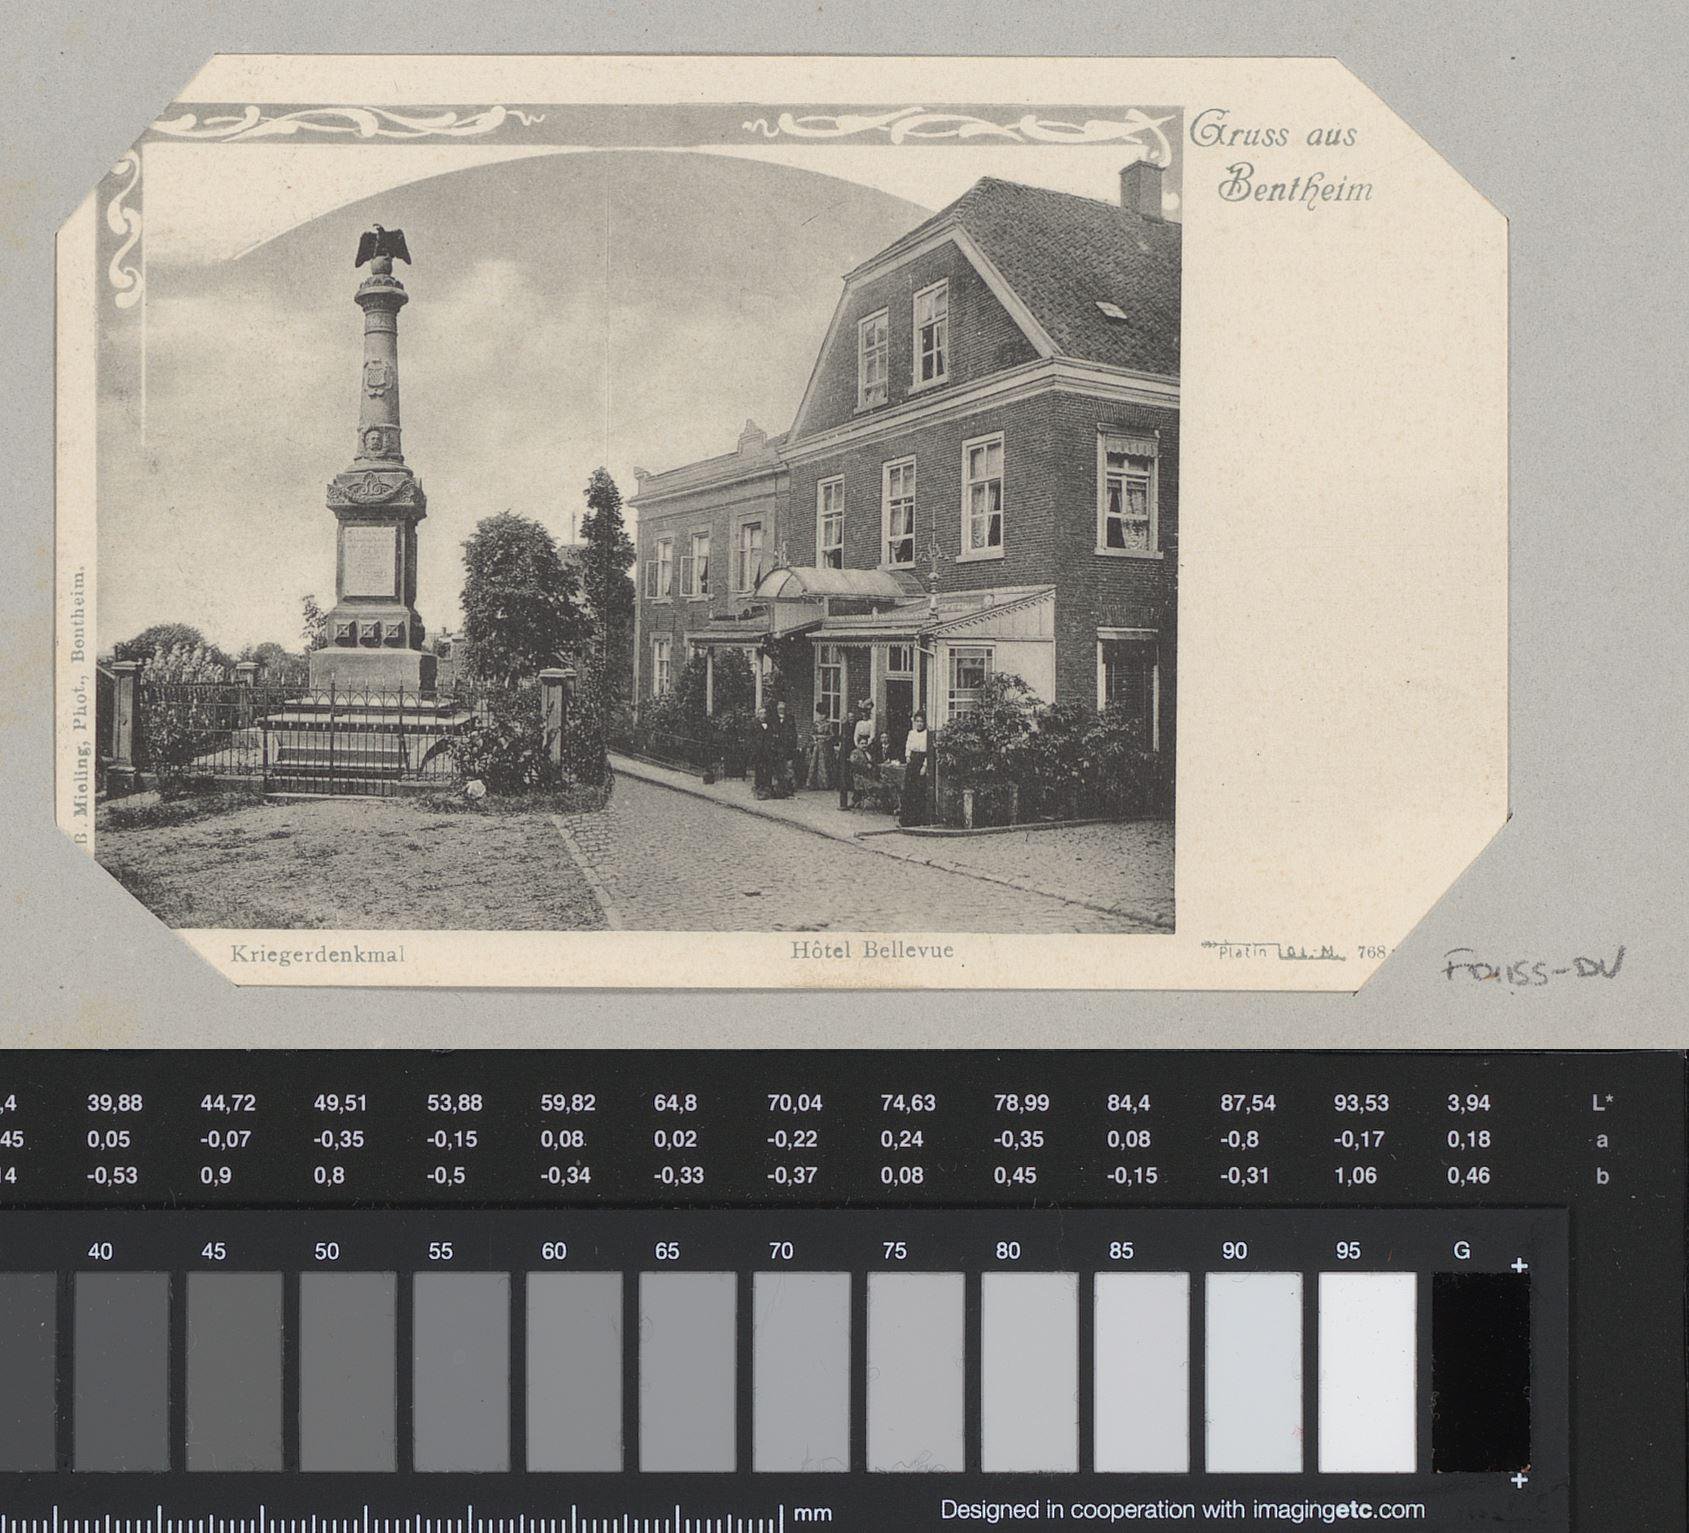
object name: album leaf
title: Gezicht op een oorlogsmonument en Hotel Bellevue te Bentheim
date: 1895-1903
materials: cardboard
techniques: photograph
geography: bentheim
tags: monument, statue, hotel, hostelry, inn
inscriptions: inscription: ‘Gruss aus Bentheim/ Verlag B. Mieling, Phot., Bentheim/ Kriegerdenkmal/ Hôtel Bellevue/ [Platin OL. M. 768:02]’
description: Deze prent maakt deel uit van een album.